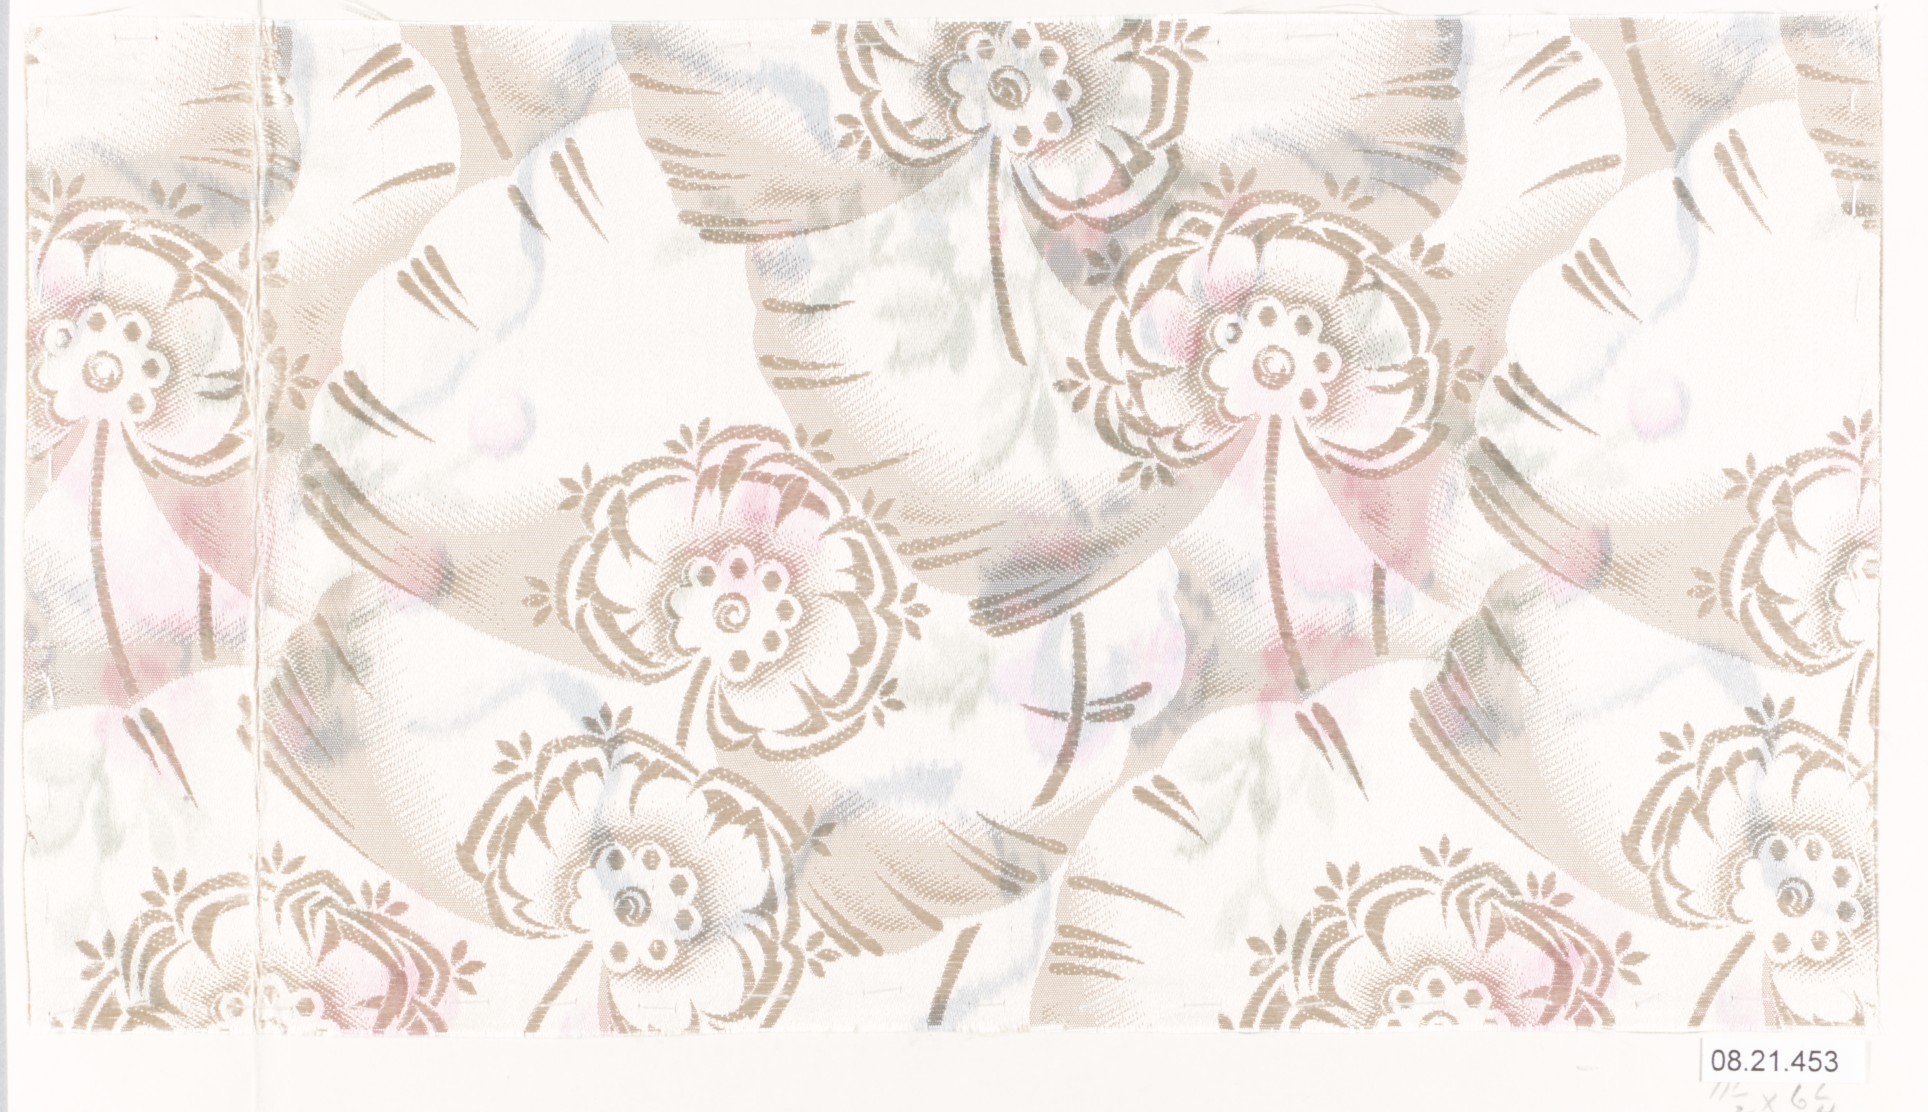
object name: textile sample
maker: Anonymous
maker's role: designer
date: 1900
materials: silk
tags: flowers